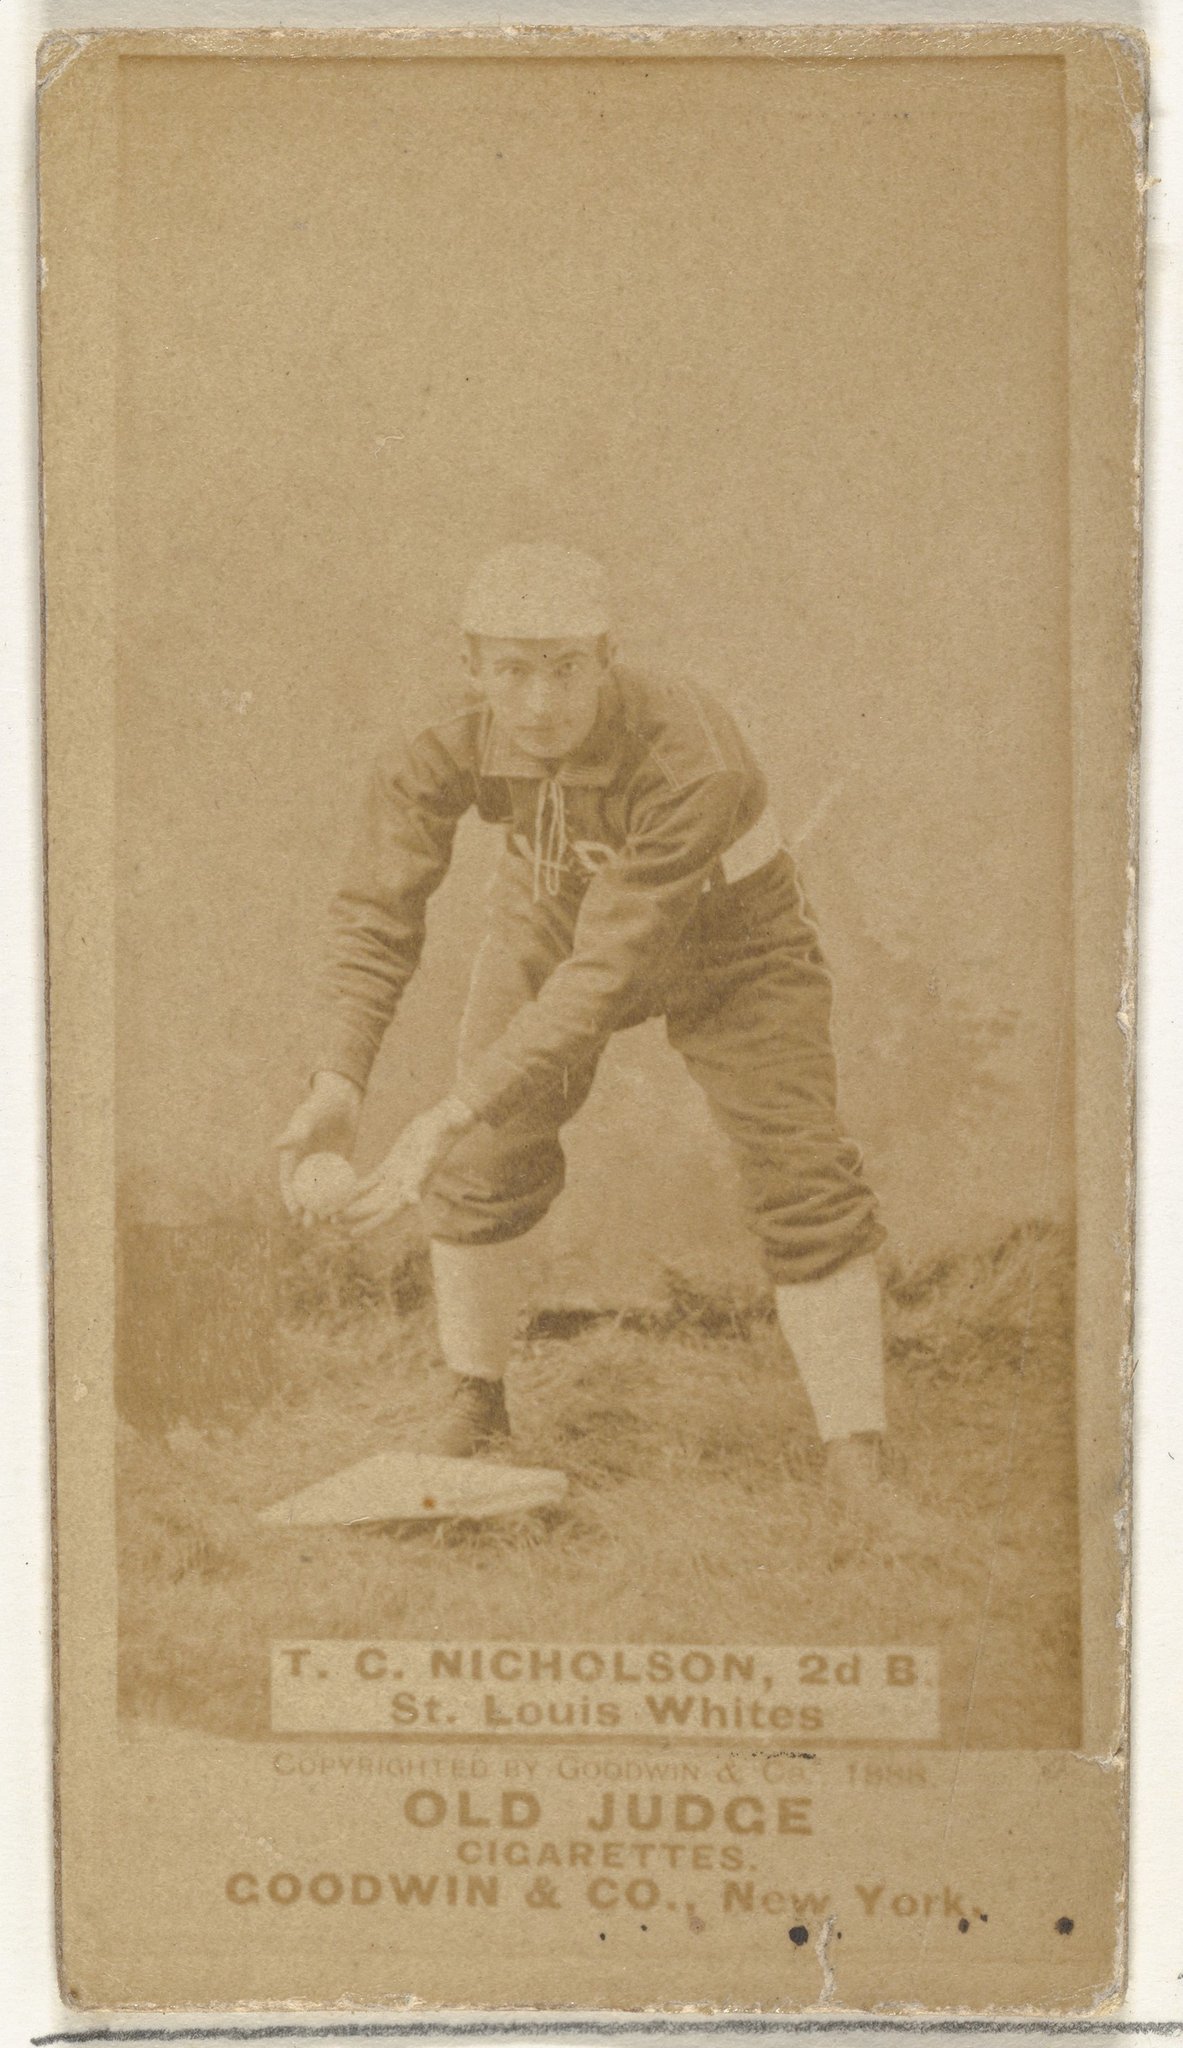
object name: baseball card, photograph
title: Nicholson, 2nd Base, St. Louis Whites, from the Old Judge series (N172) for Old Judge Cigarettes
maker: goodwin & company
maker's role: publisher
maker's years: 1850-1950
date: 1888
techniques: albumen silver print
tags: men,portraits,baseball,athletes